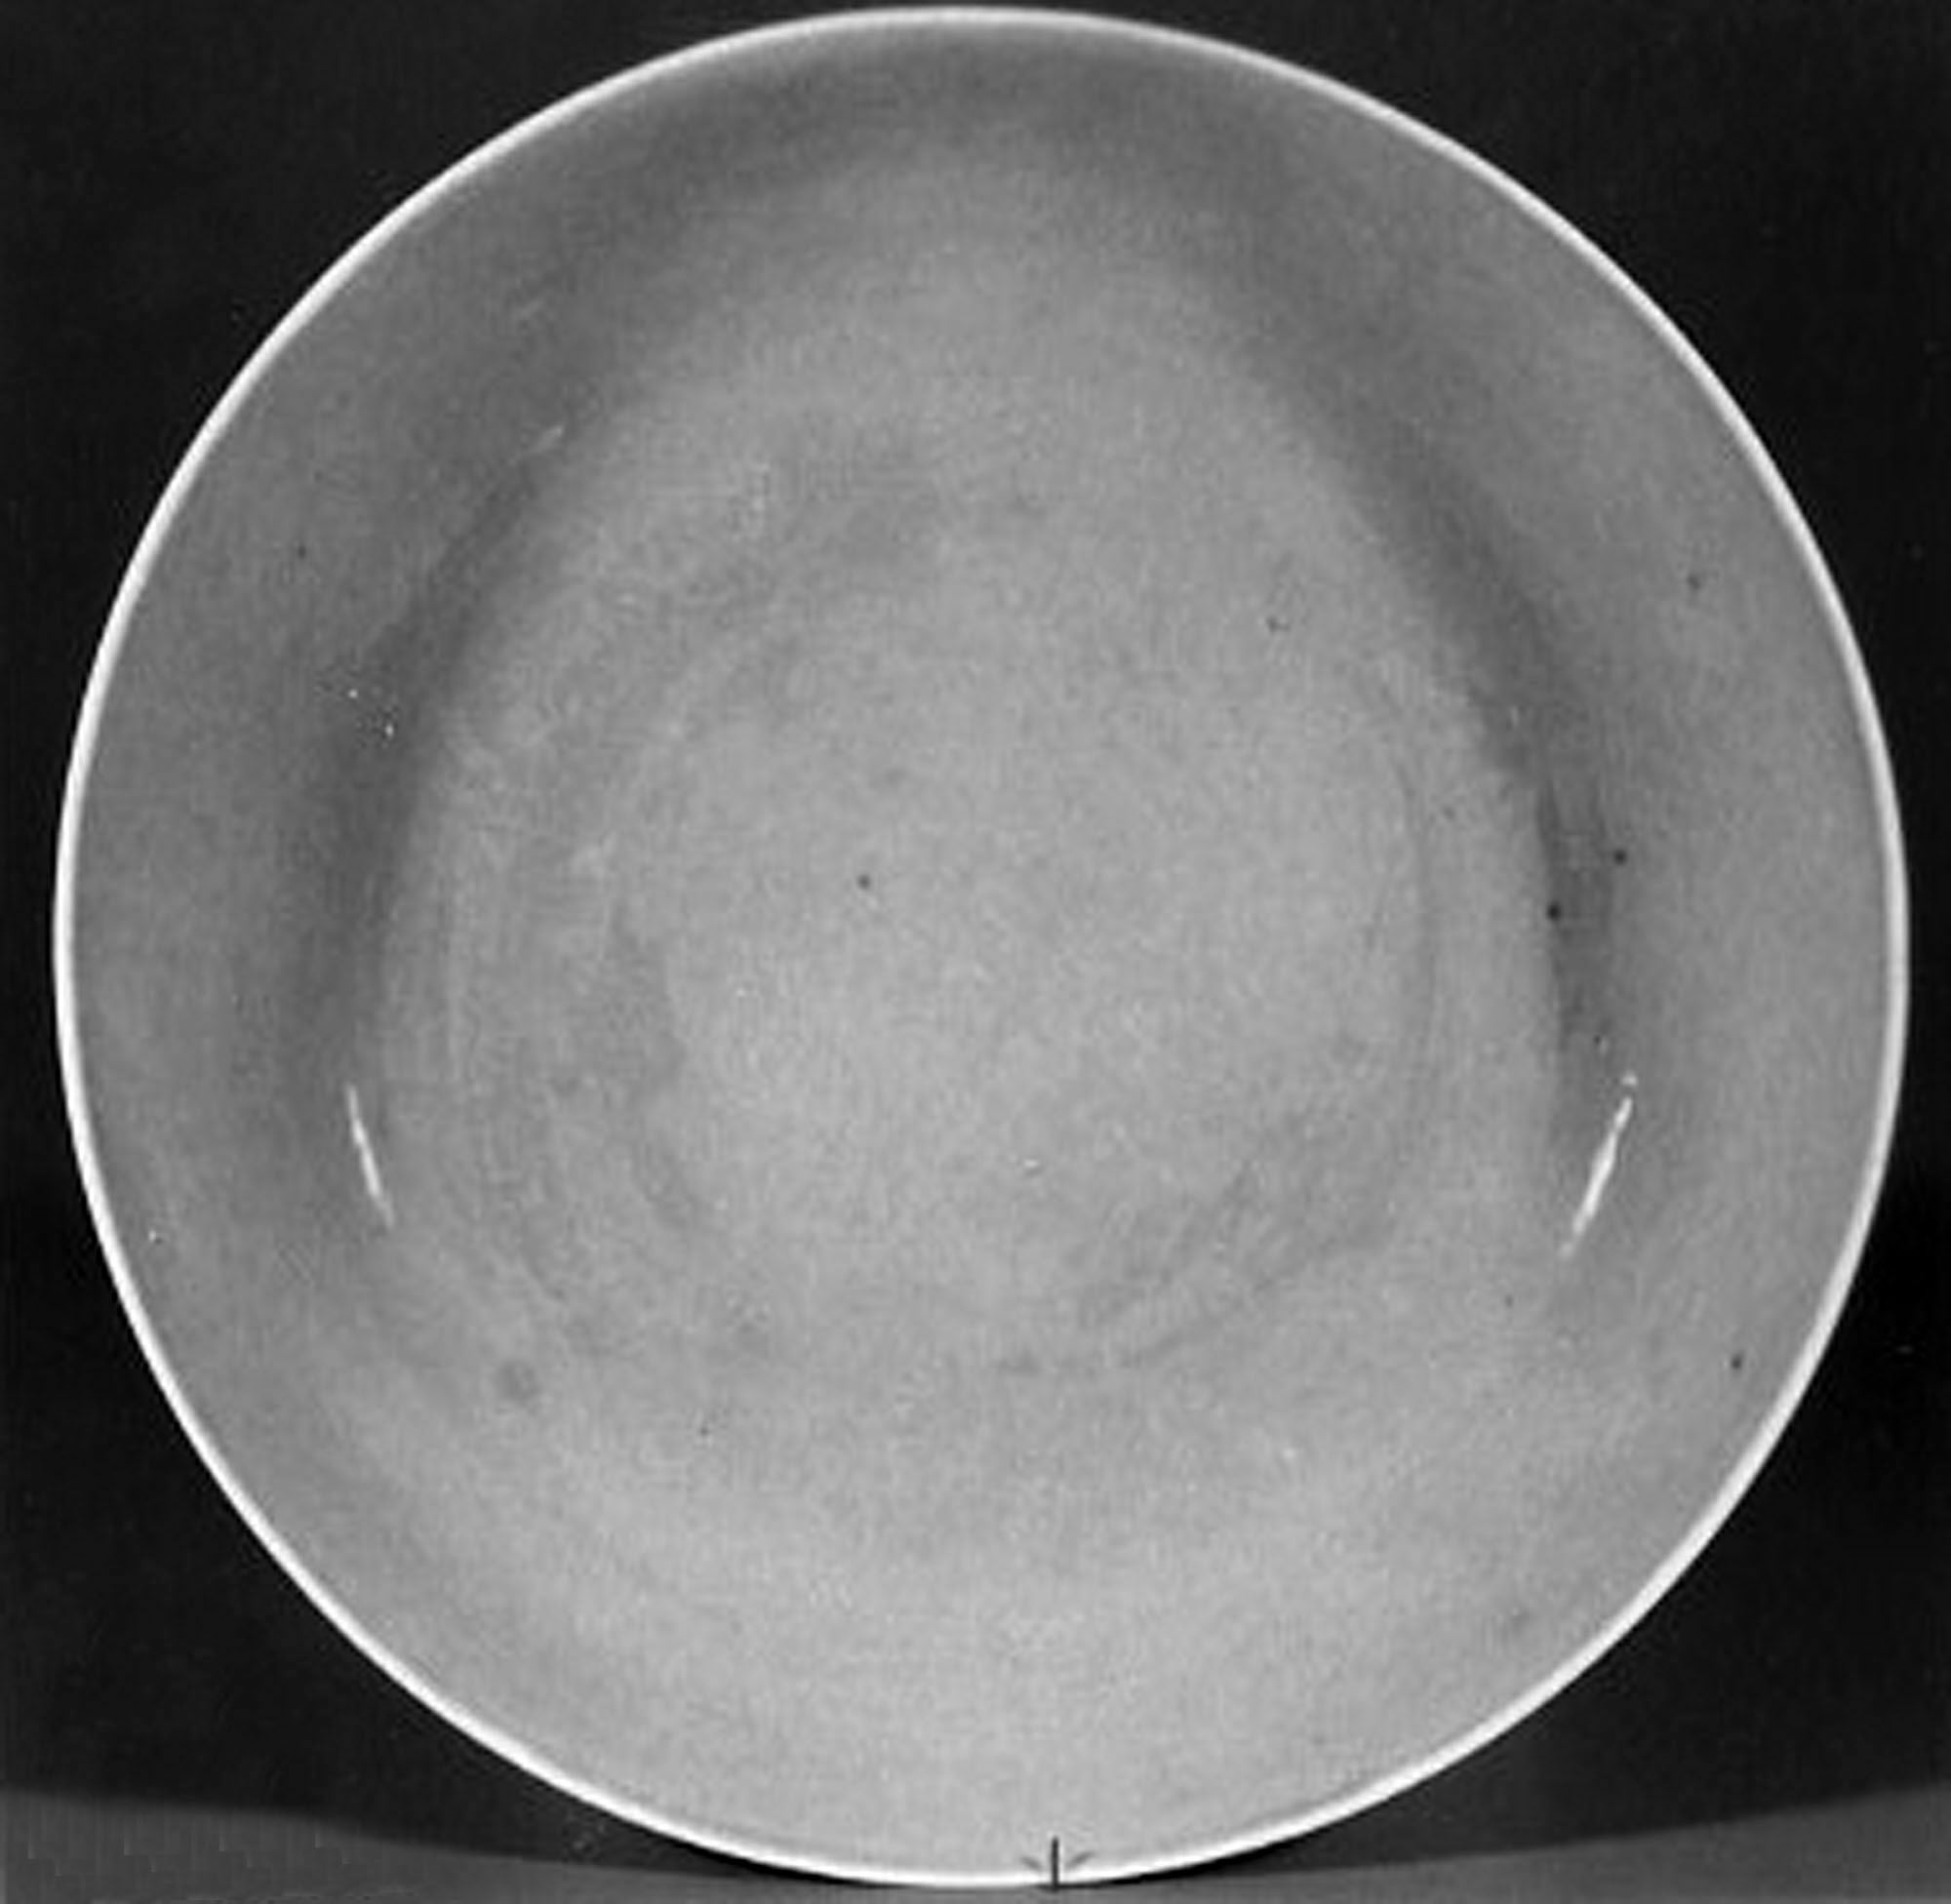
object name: dish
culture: chinese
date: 1875-1908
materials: porcelain